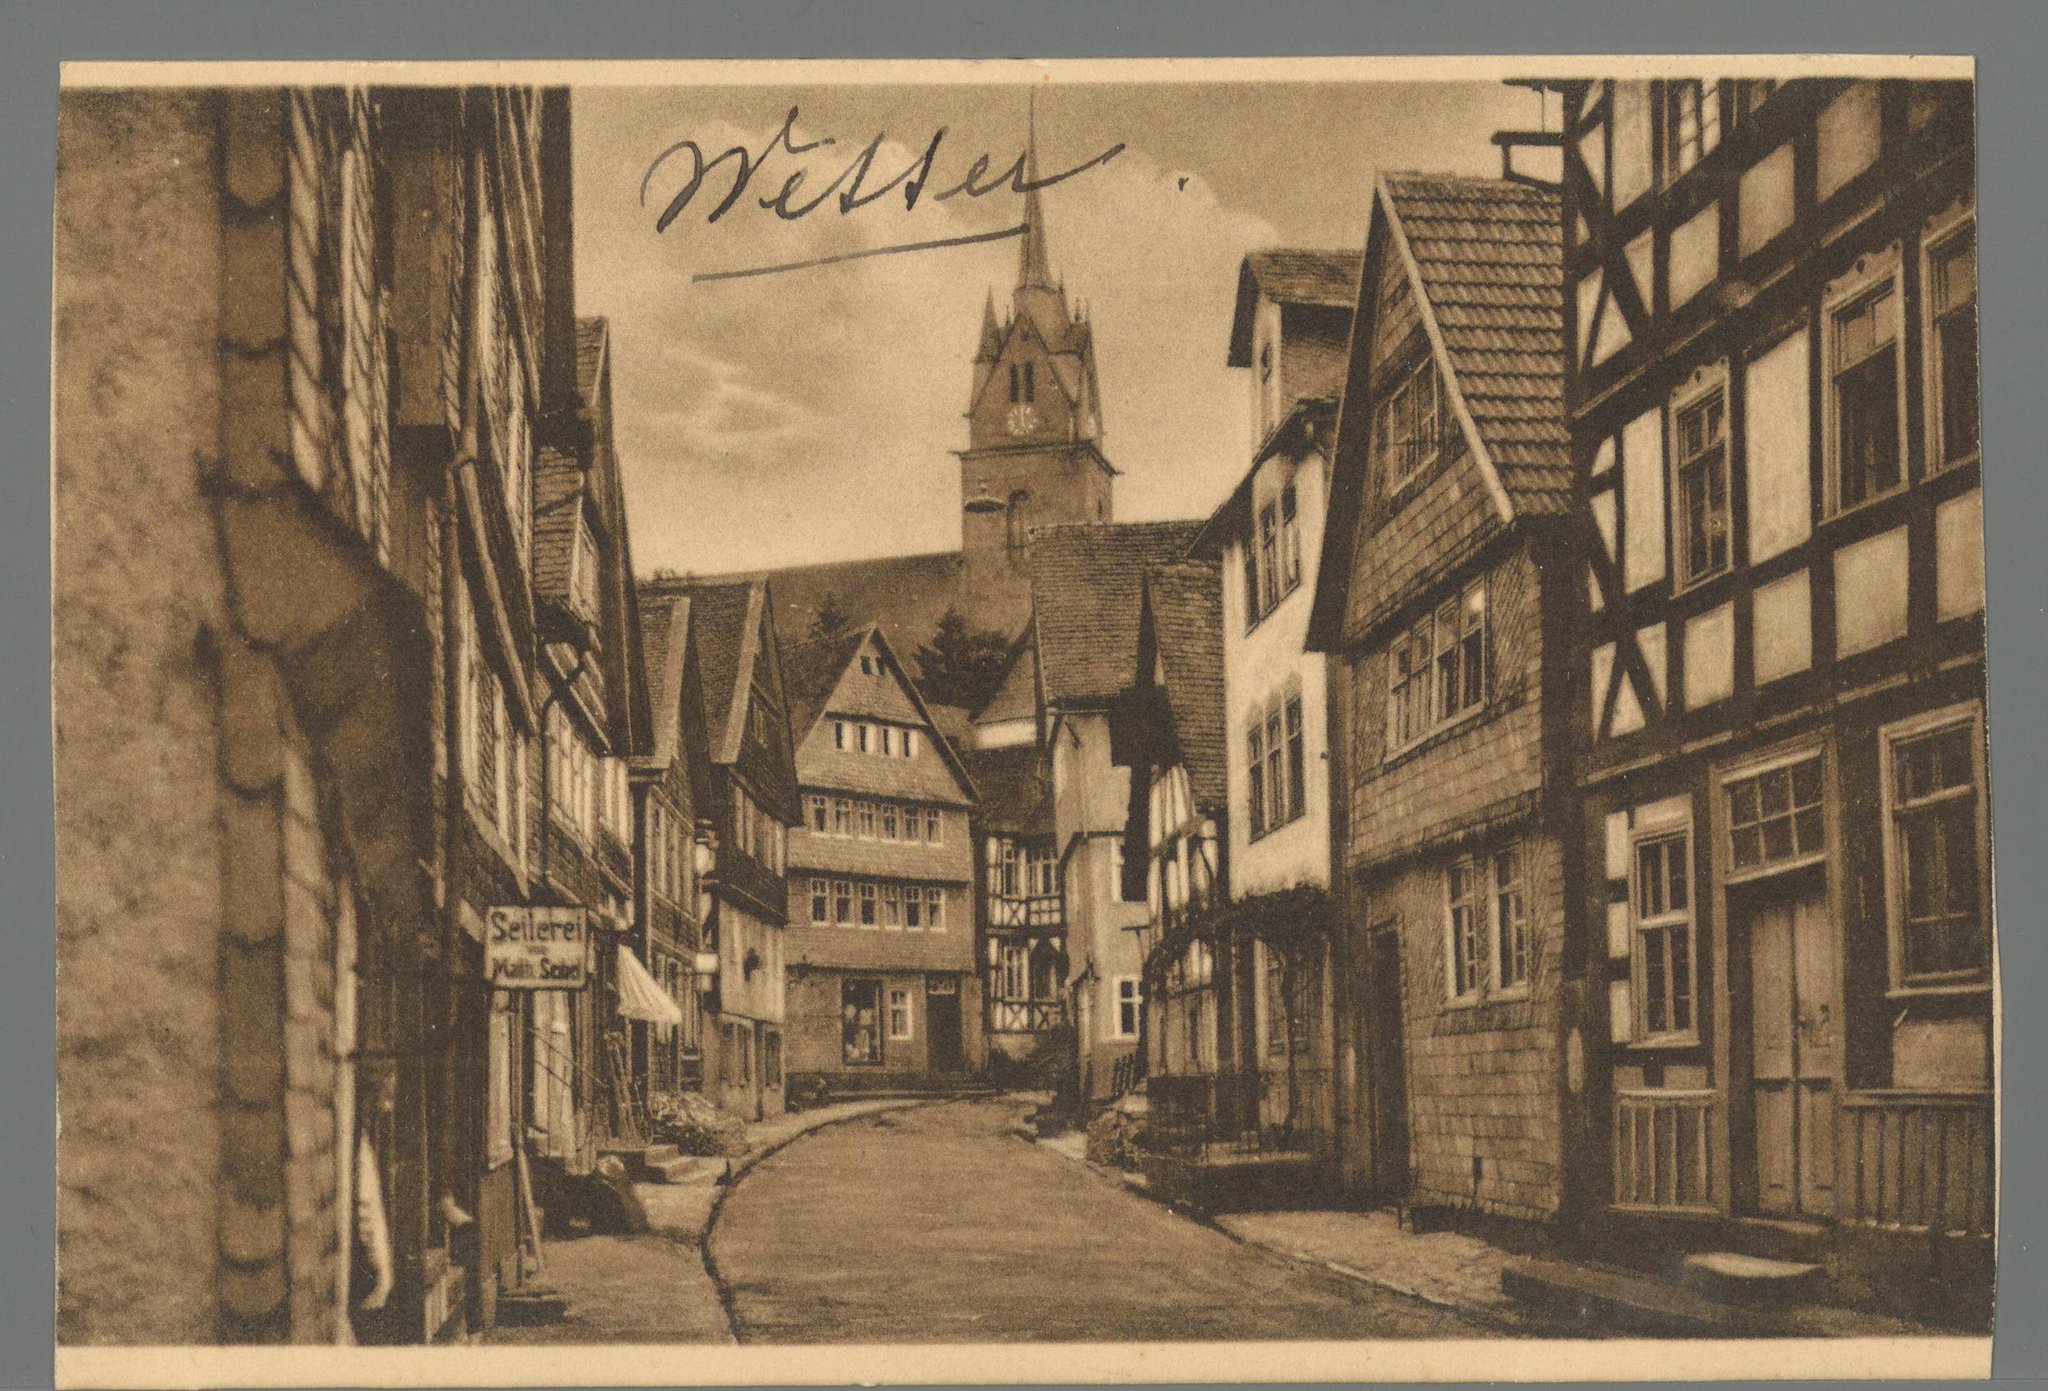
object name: ansichtkaart, prentbriefkaart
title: Wetter (Hessen-Nassau). Fuhrstraβe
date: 1905-1927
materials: cardboard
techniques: photograph, writing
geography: wetter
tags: church (exterior), street